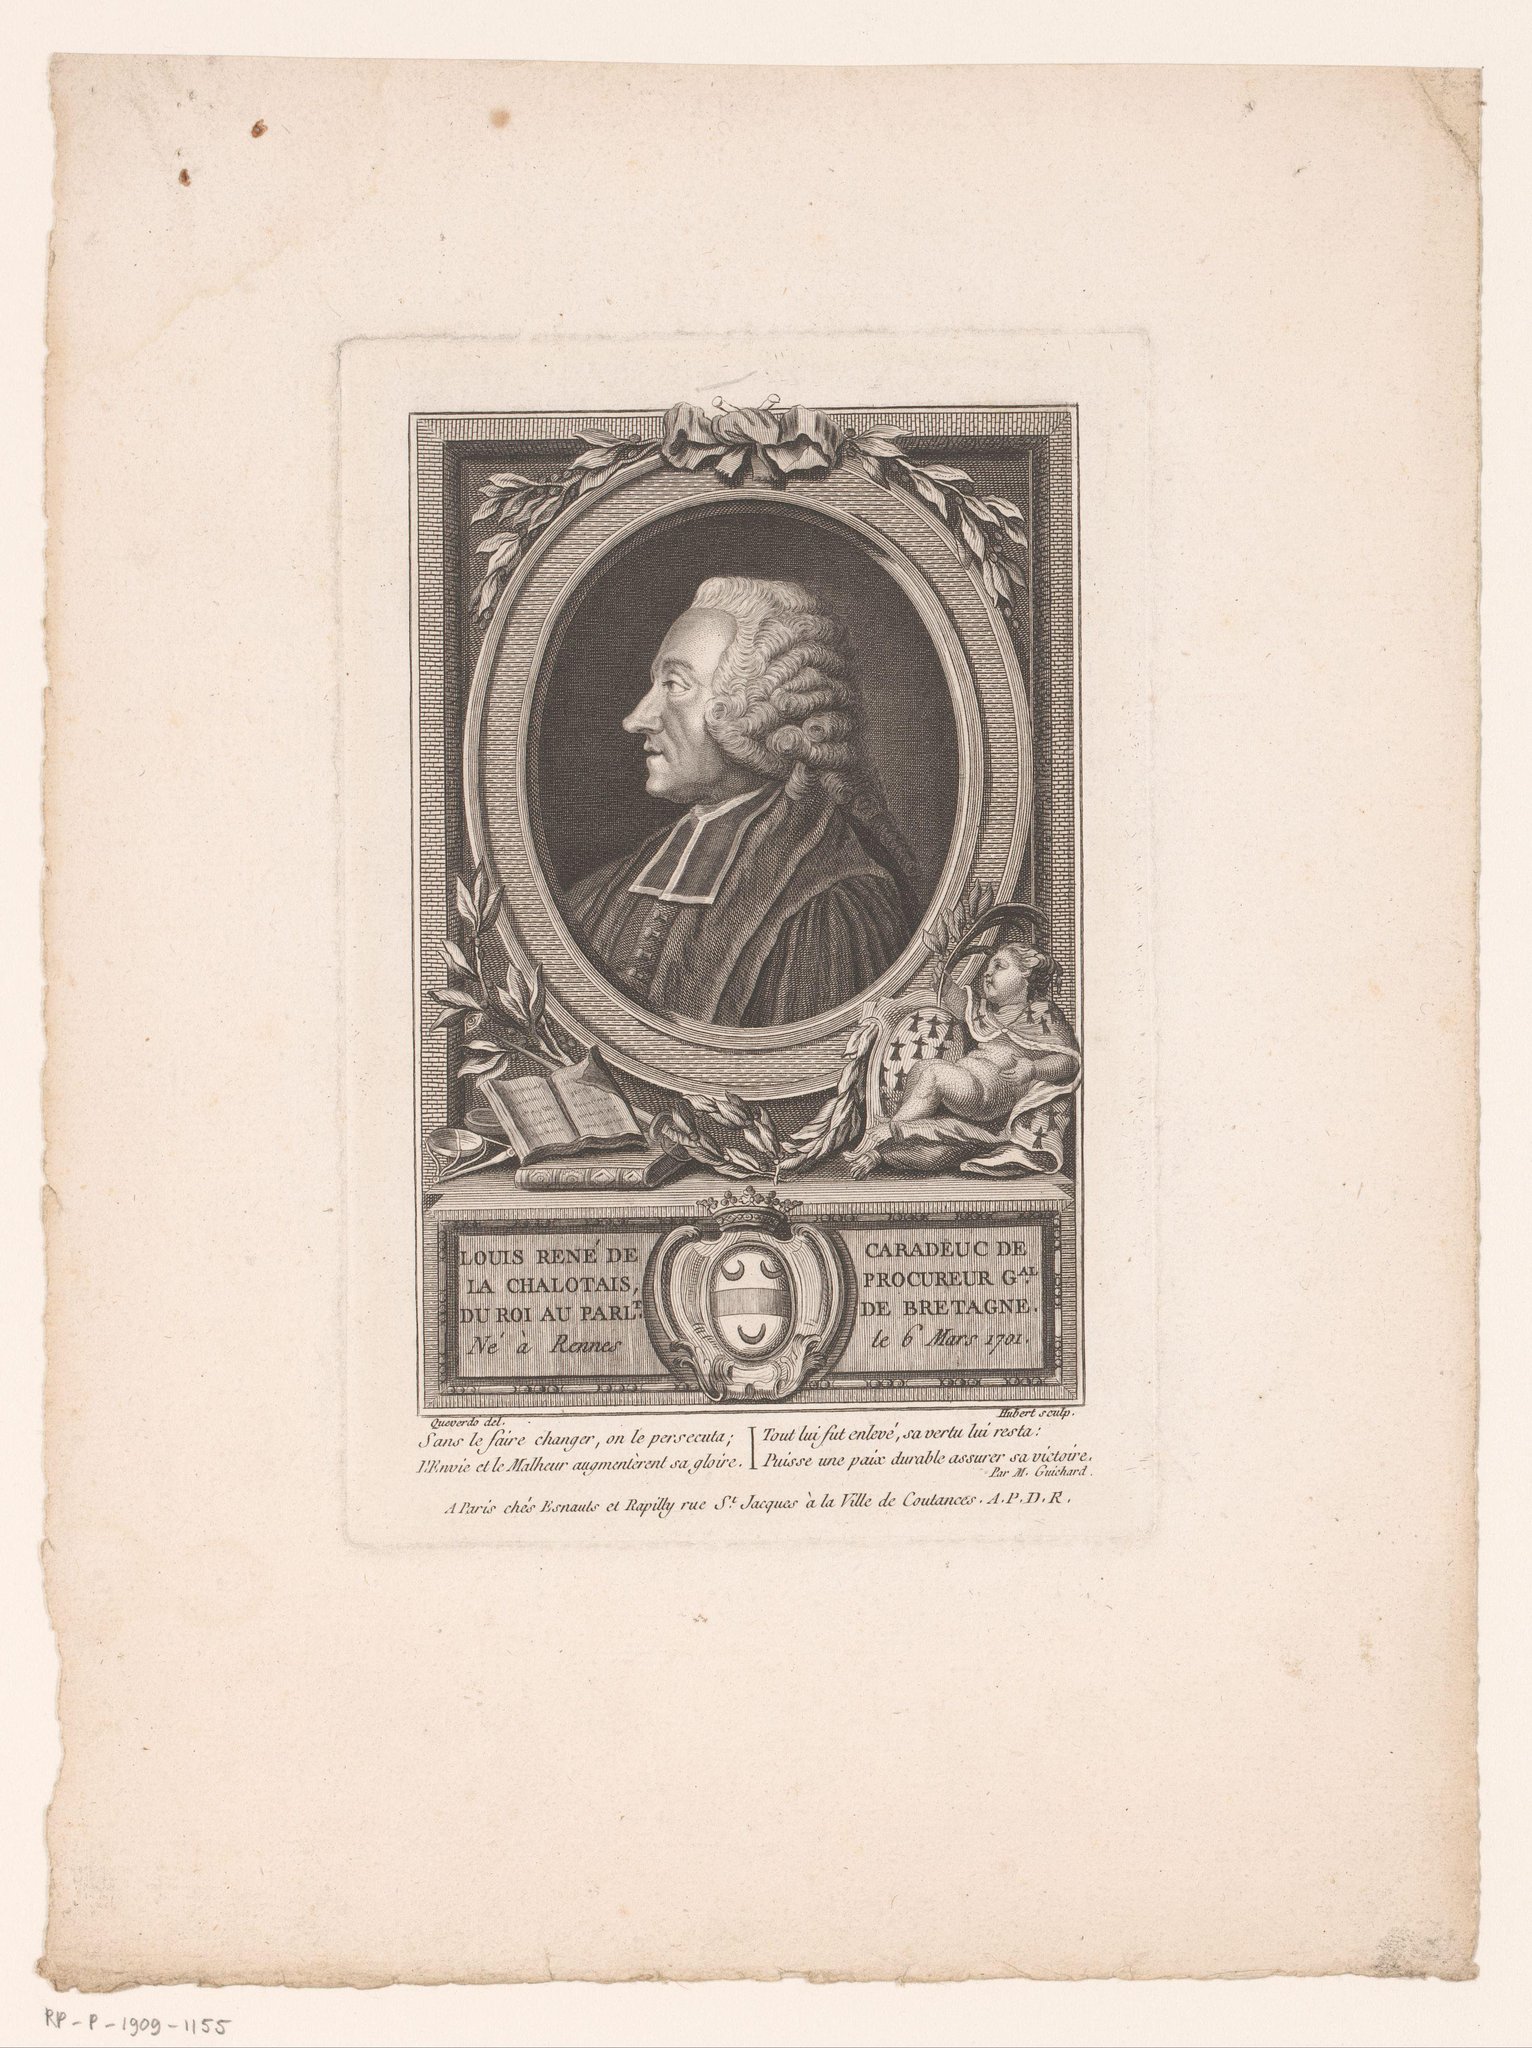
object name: print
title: Portret van Louis-René de Caradeuc de la Chalotais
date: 1754-1809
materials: paper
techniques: engraving, etching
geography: france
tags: historical persons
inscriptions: collector's mark: Lugt 2228